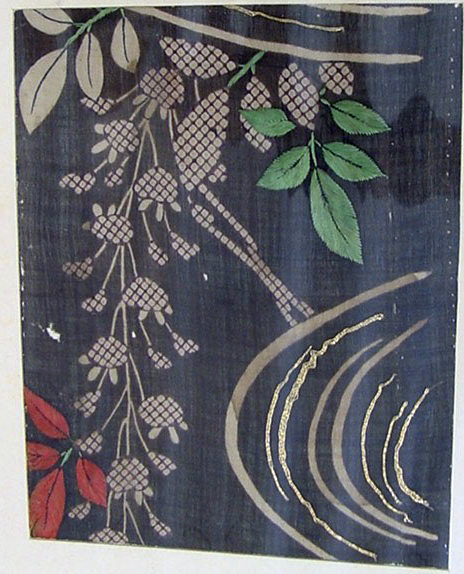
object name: piece from a kosode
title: Piece from a Summer Kosode (katabira) with Wisteria above a Stream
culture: japanese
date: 1615-1868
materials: fiber, metal thread, silk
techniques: dyeing, embroidery, weave, resist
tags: flowers